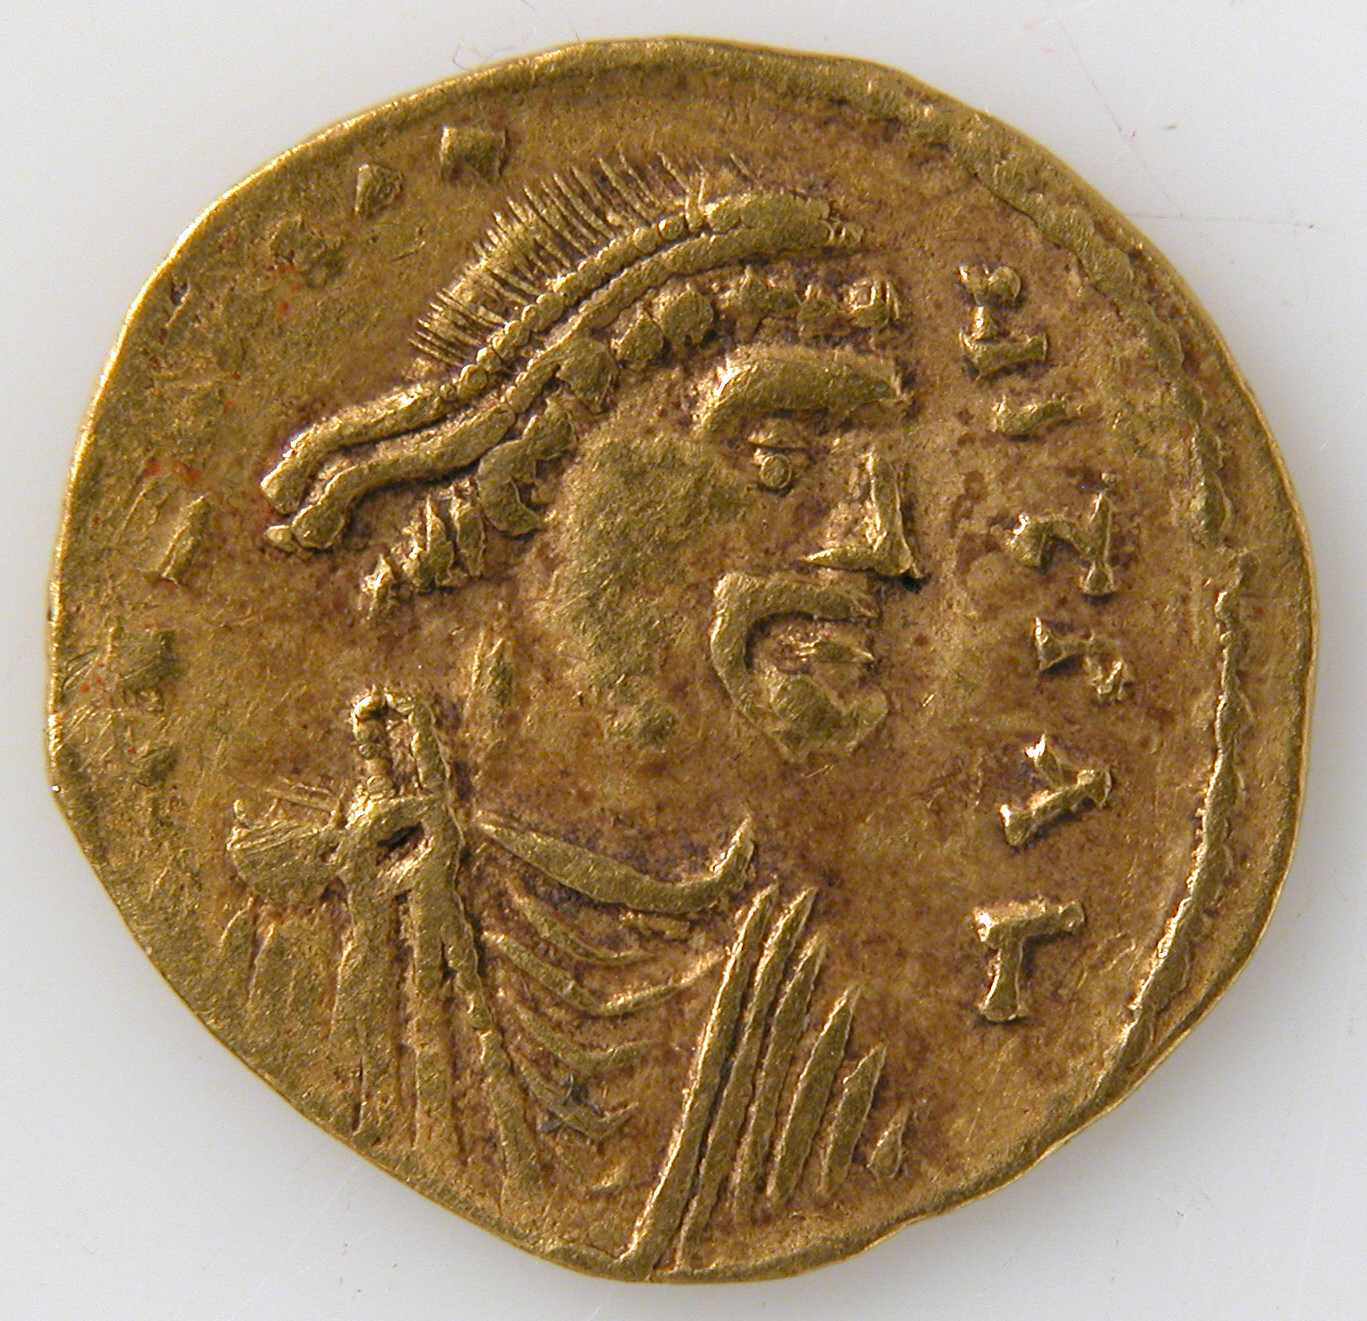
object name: tremissis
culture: byzantine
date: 668-685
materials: gold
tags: emperors,men,profiles